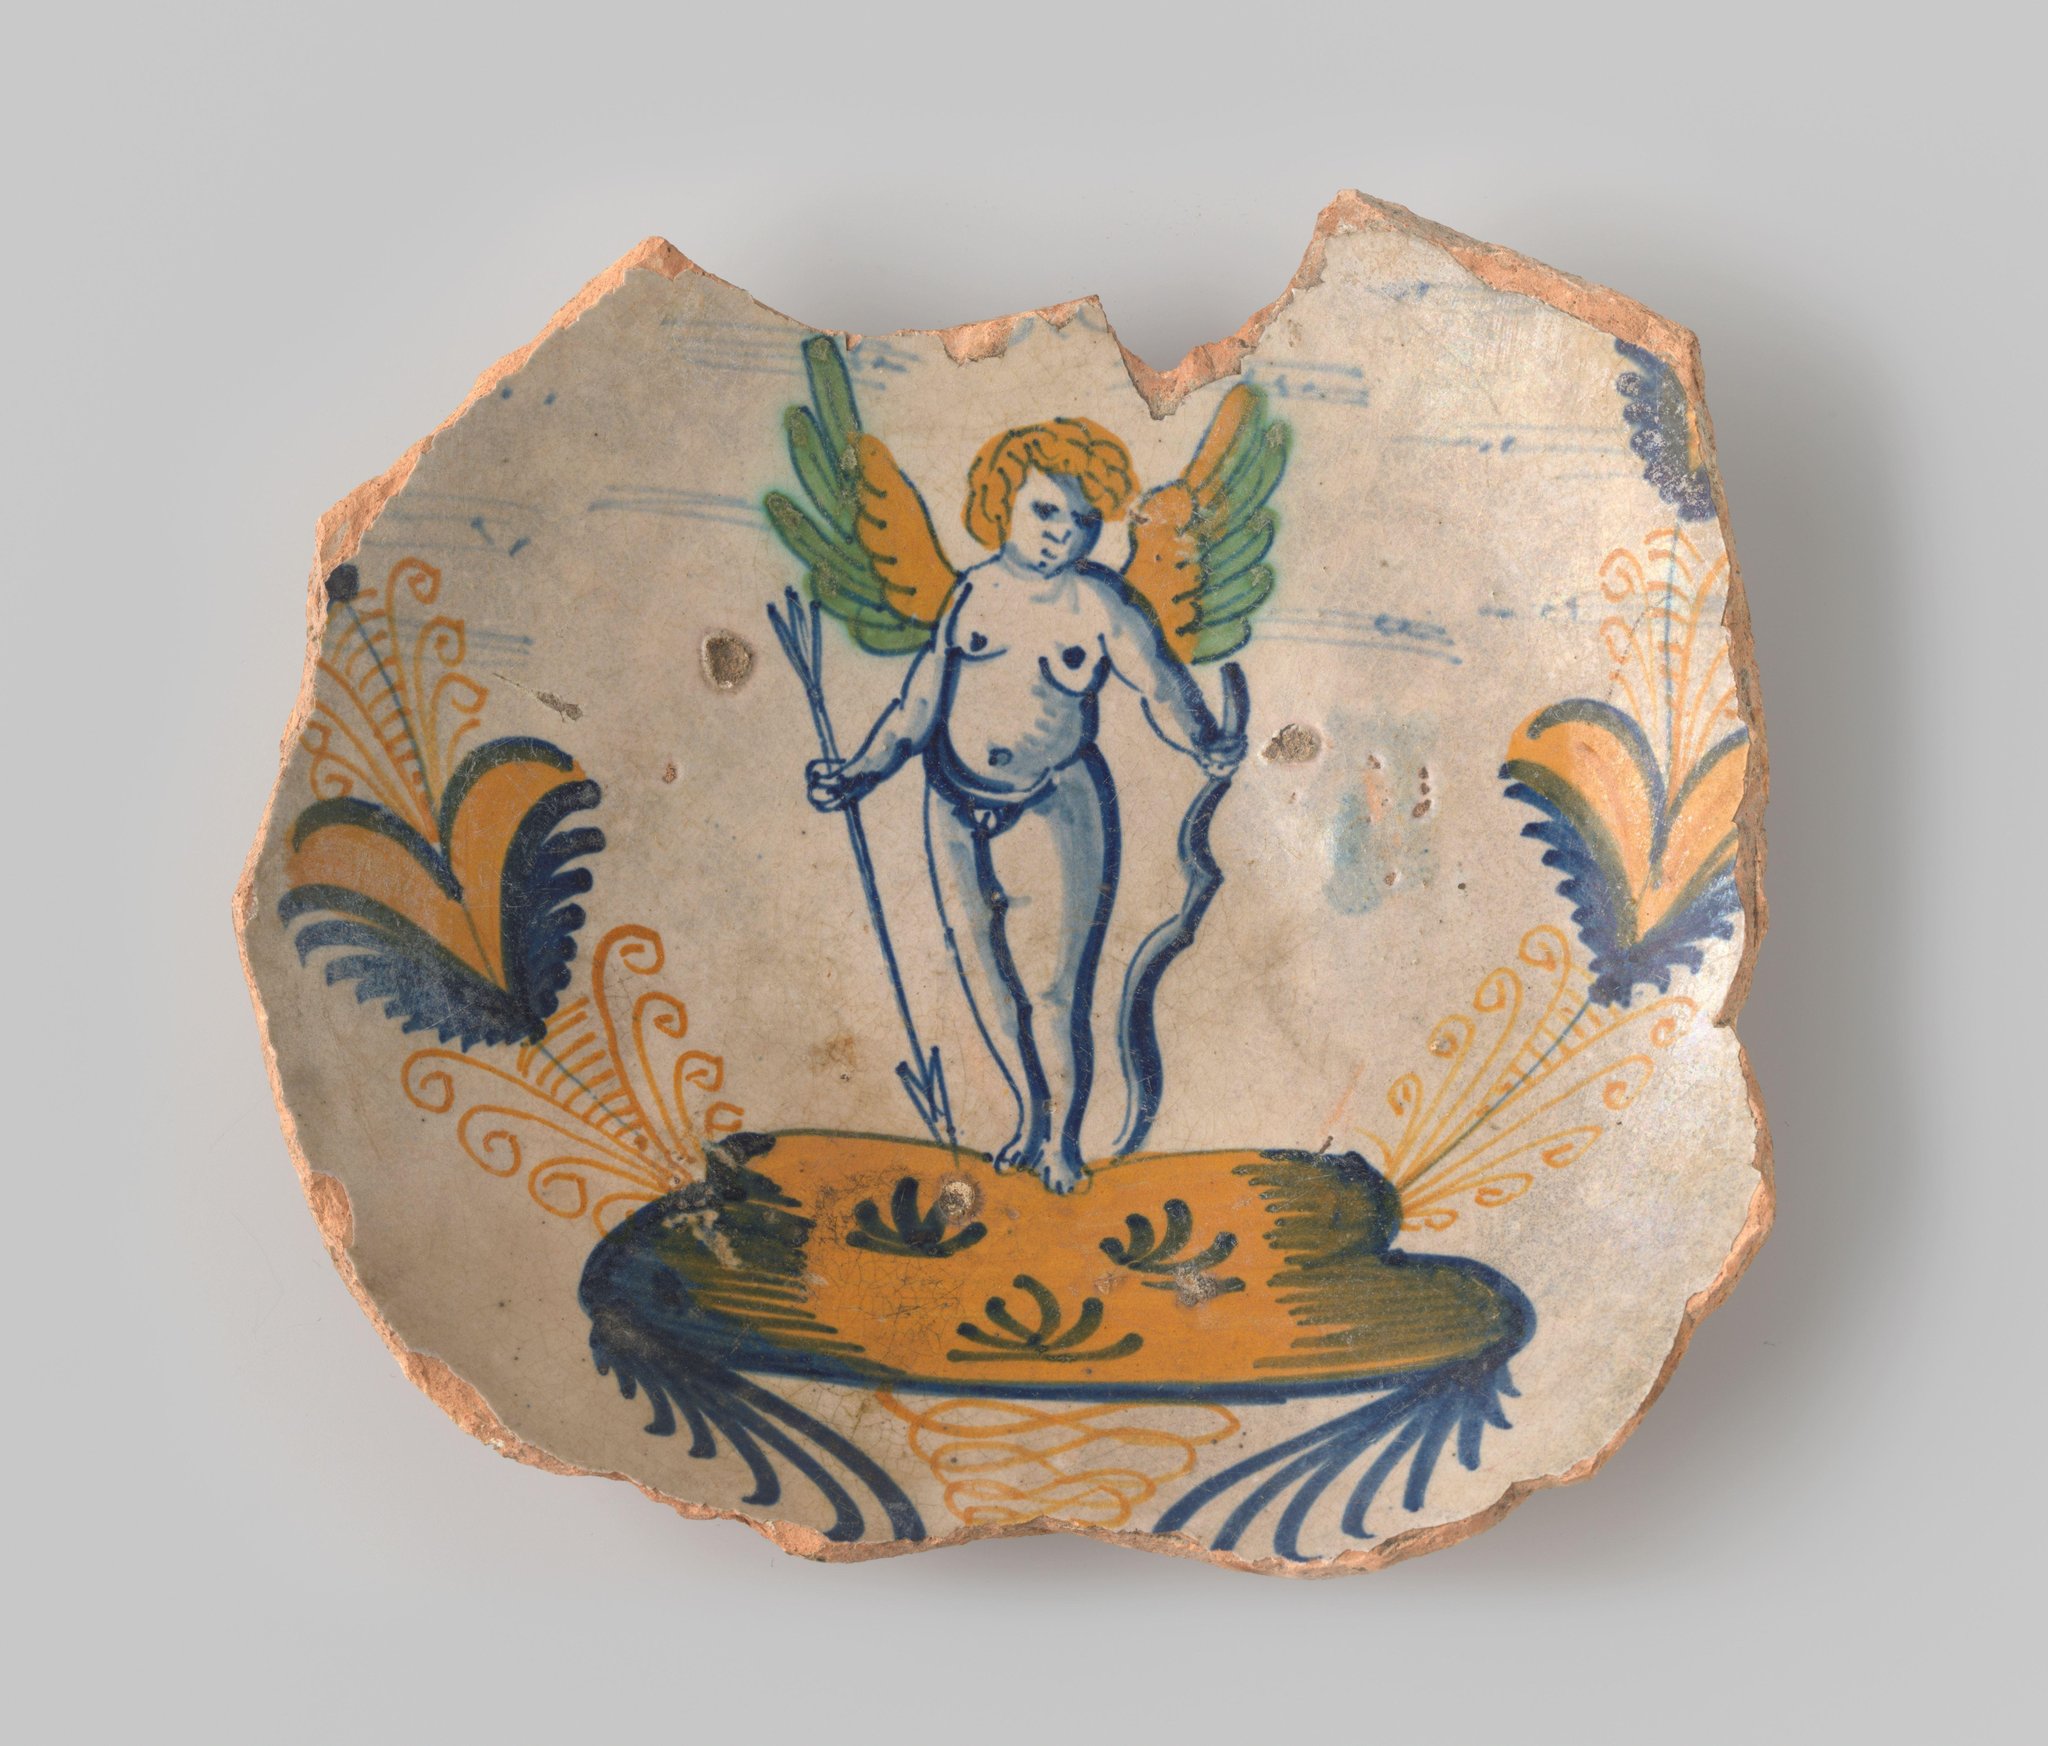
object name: fragment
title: Fragment in de vorm van een bodem van een schotel, beschilderd met een putto tussen twee aigretten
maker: Anonymous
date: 1600-1650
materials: earthenware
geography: north holland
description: Fragment in de vorm van een bodem van een schotel, beschilderd in blauw, oranje en groen met een putto (Amor met pijl en boog) op een grondje tussen twee aigretten.